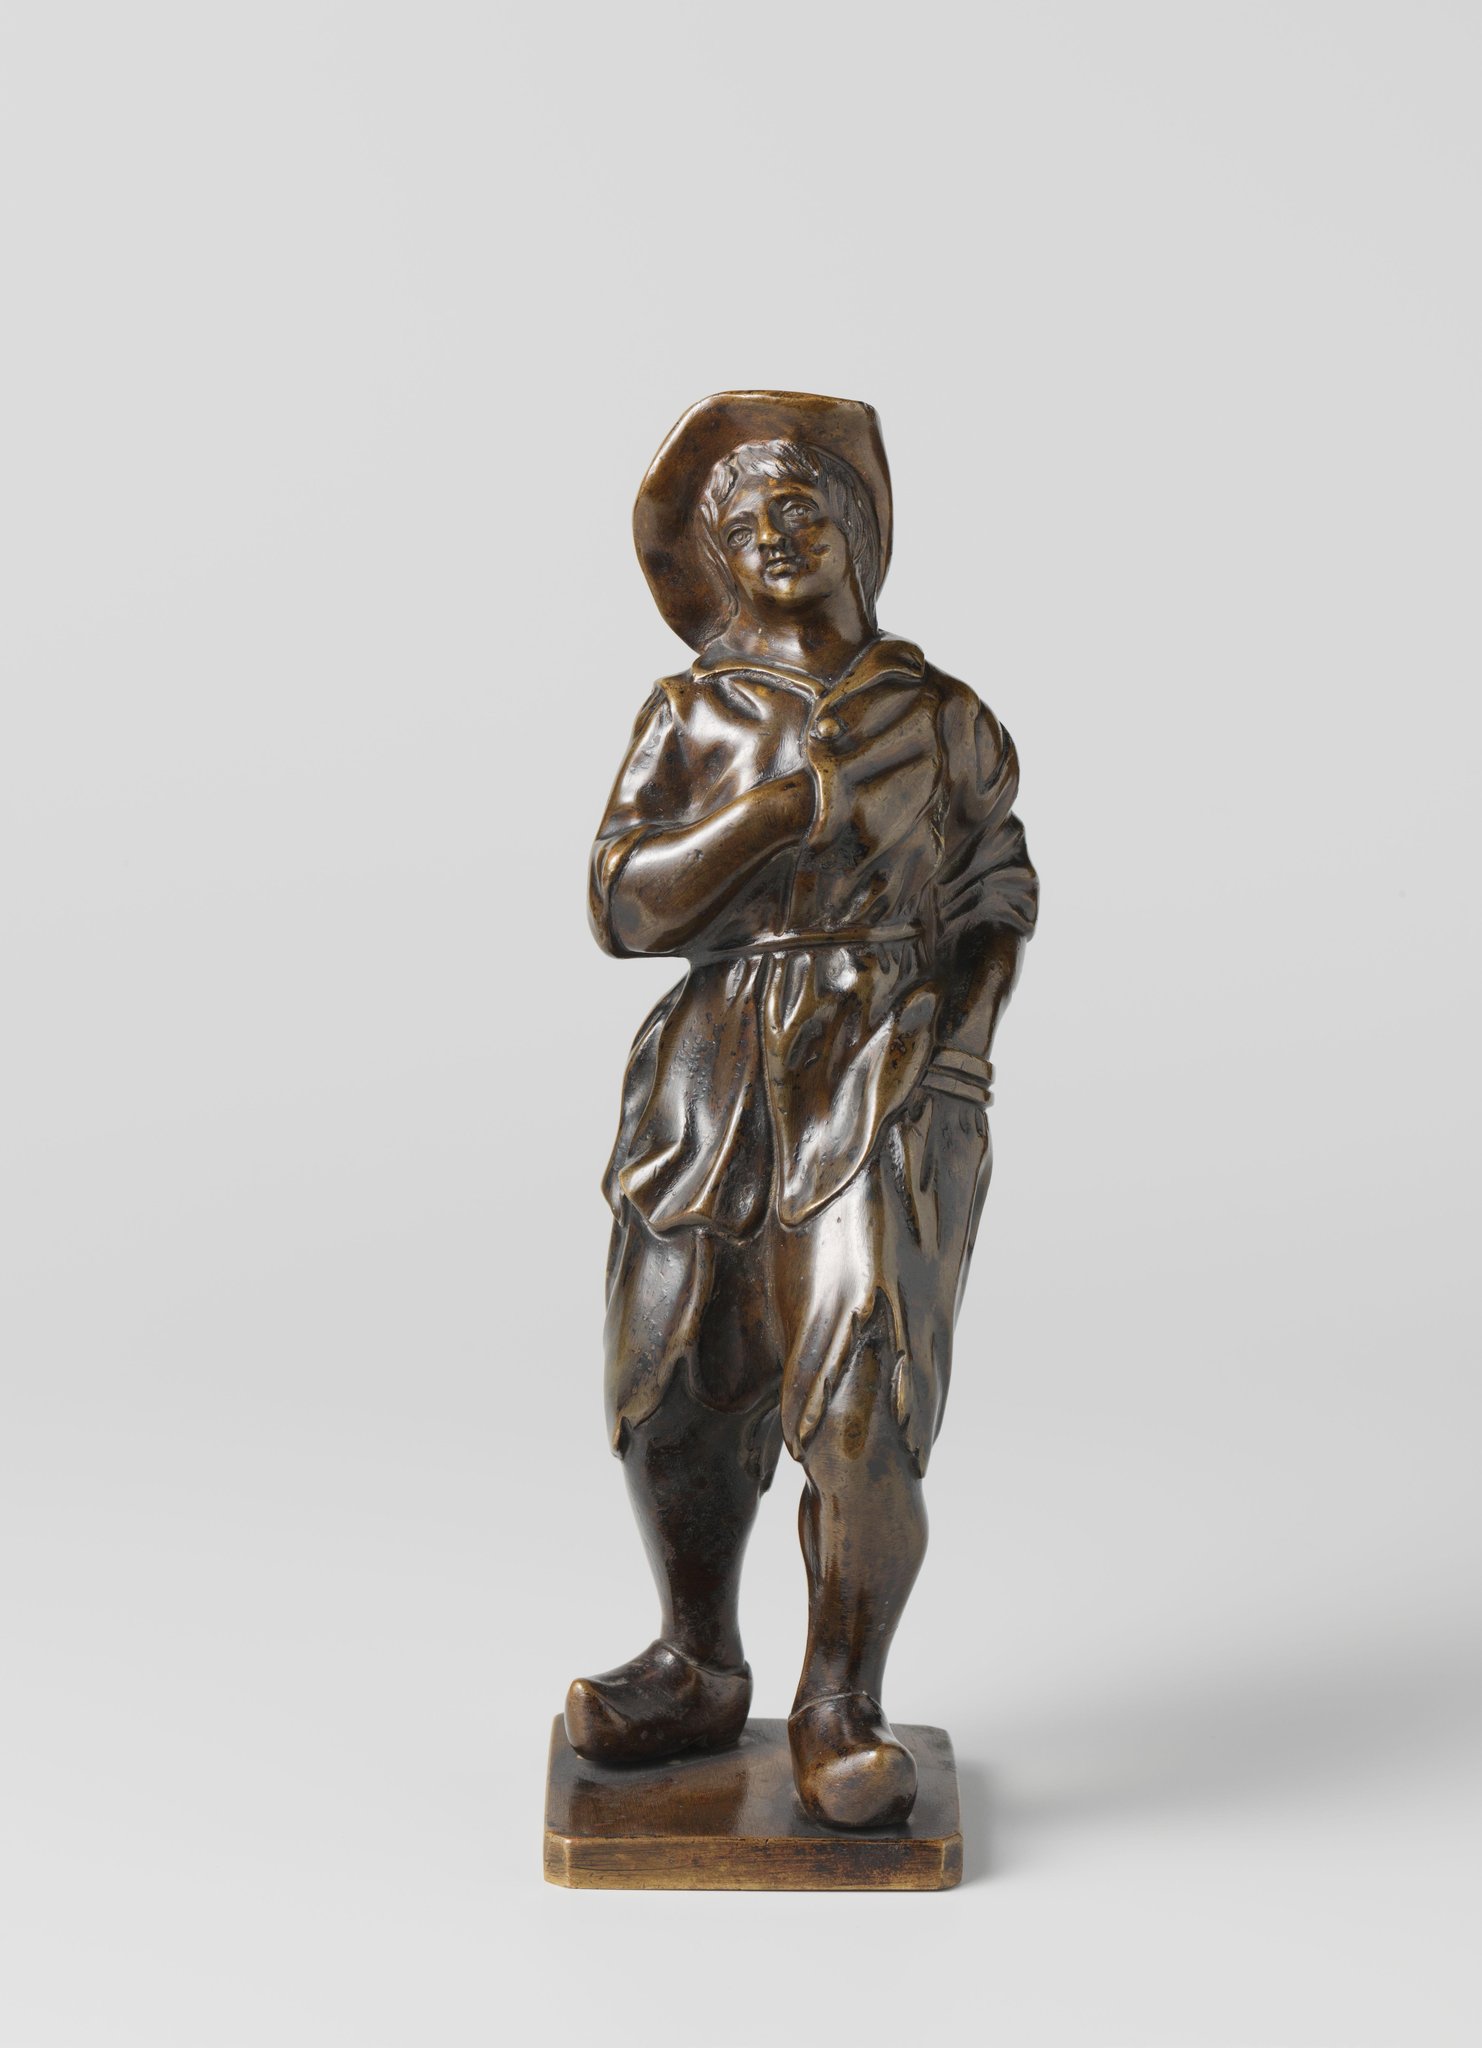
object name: sculpture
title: Peasant Boy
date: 1670-1750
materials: bronze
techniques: casting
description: Pieter Xavery, c. 1647 - 1674, attributed. Country boy and girl, bronze.